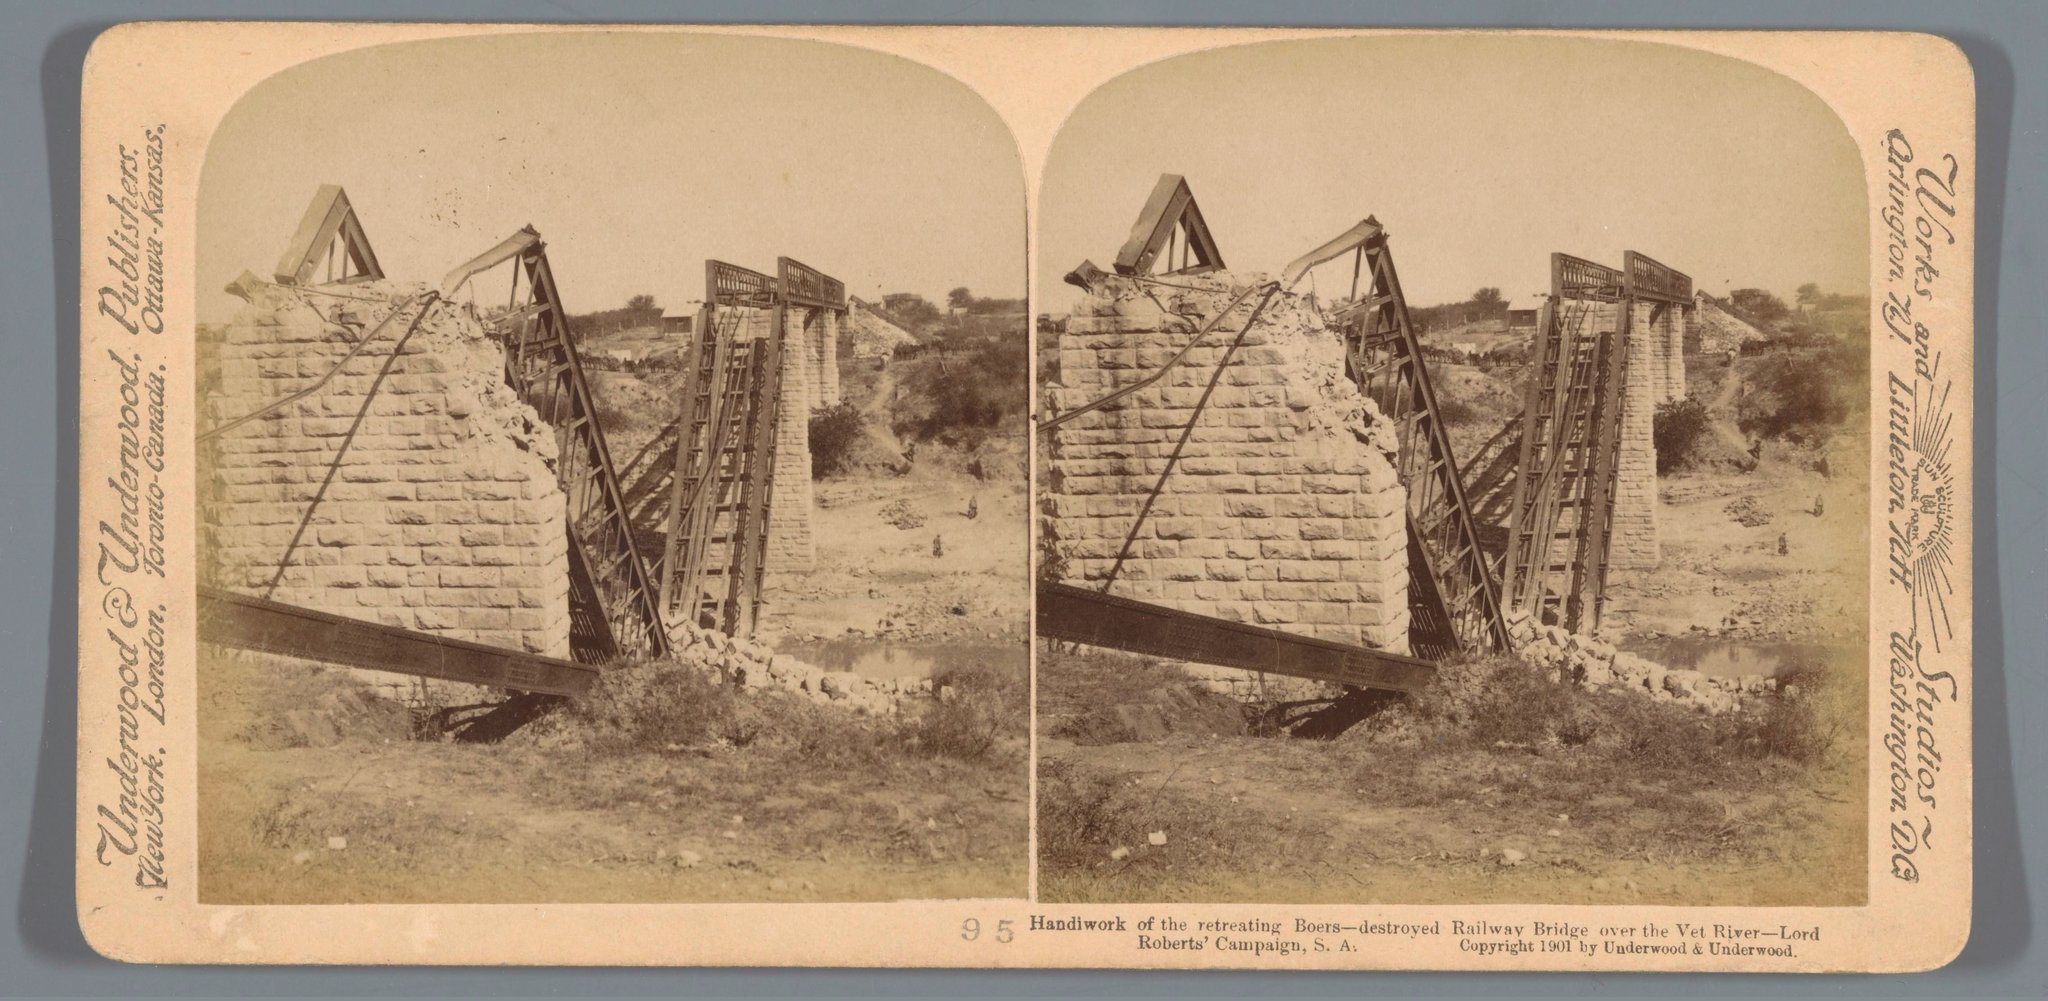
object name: stereograph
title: Handiwork of the retreating Boers, destroyed Railway Bridges over the Vet River - Lord Roberts' Campaign, S.A.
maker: Anonymous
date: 1901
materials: cardboard, paper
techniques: albumen print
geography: new york city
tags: bridge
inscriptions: copyright notice: ‘Copyright 1901 by Underwood & Underwood.’, inscription, inscription: ‘Works and Studios ~/ Arlington, N.J. Littleton, N.H. Washington, D.C.’, number: ‘95’